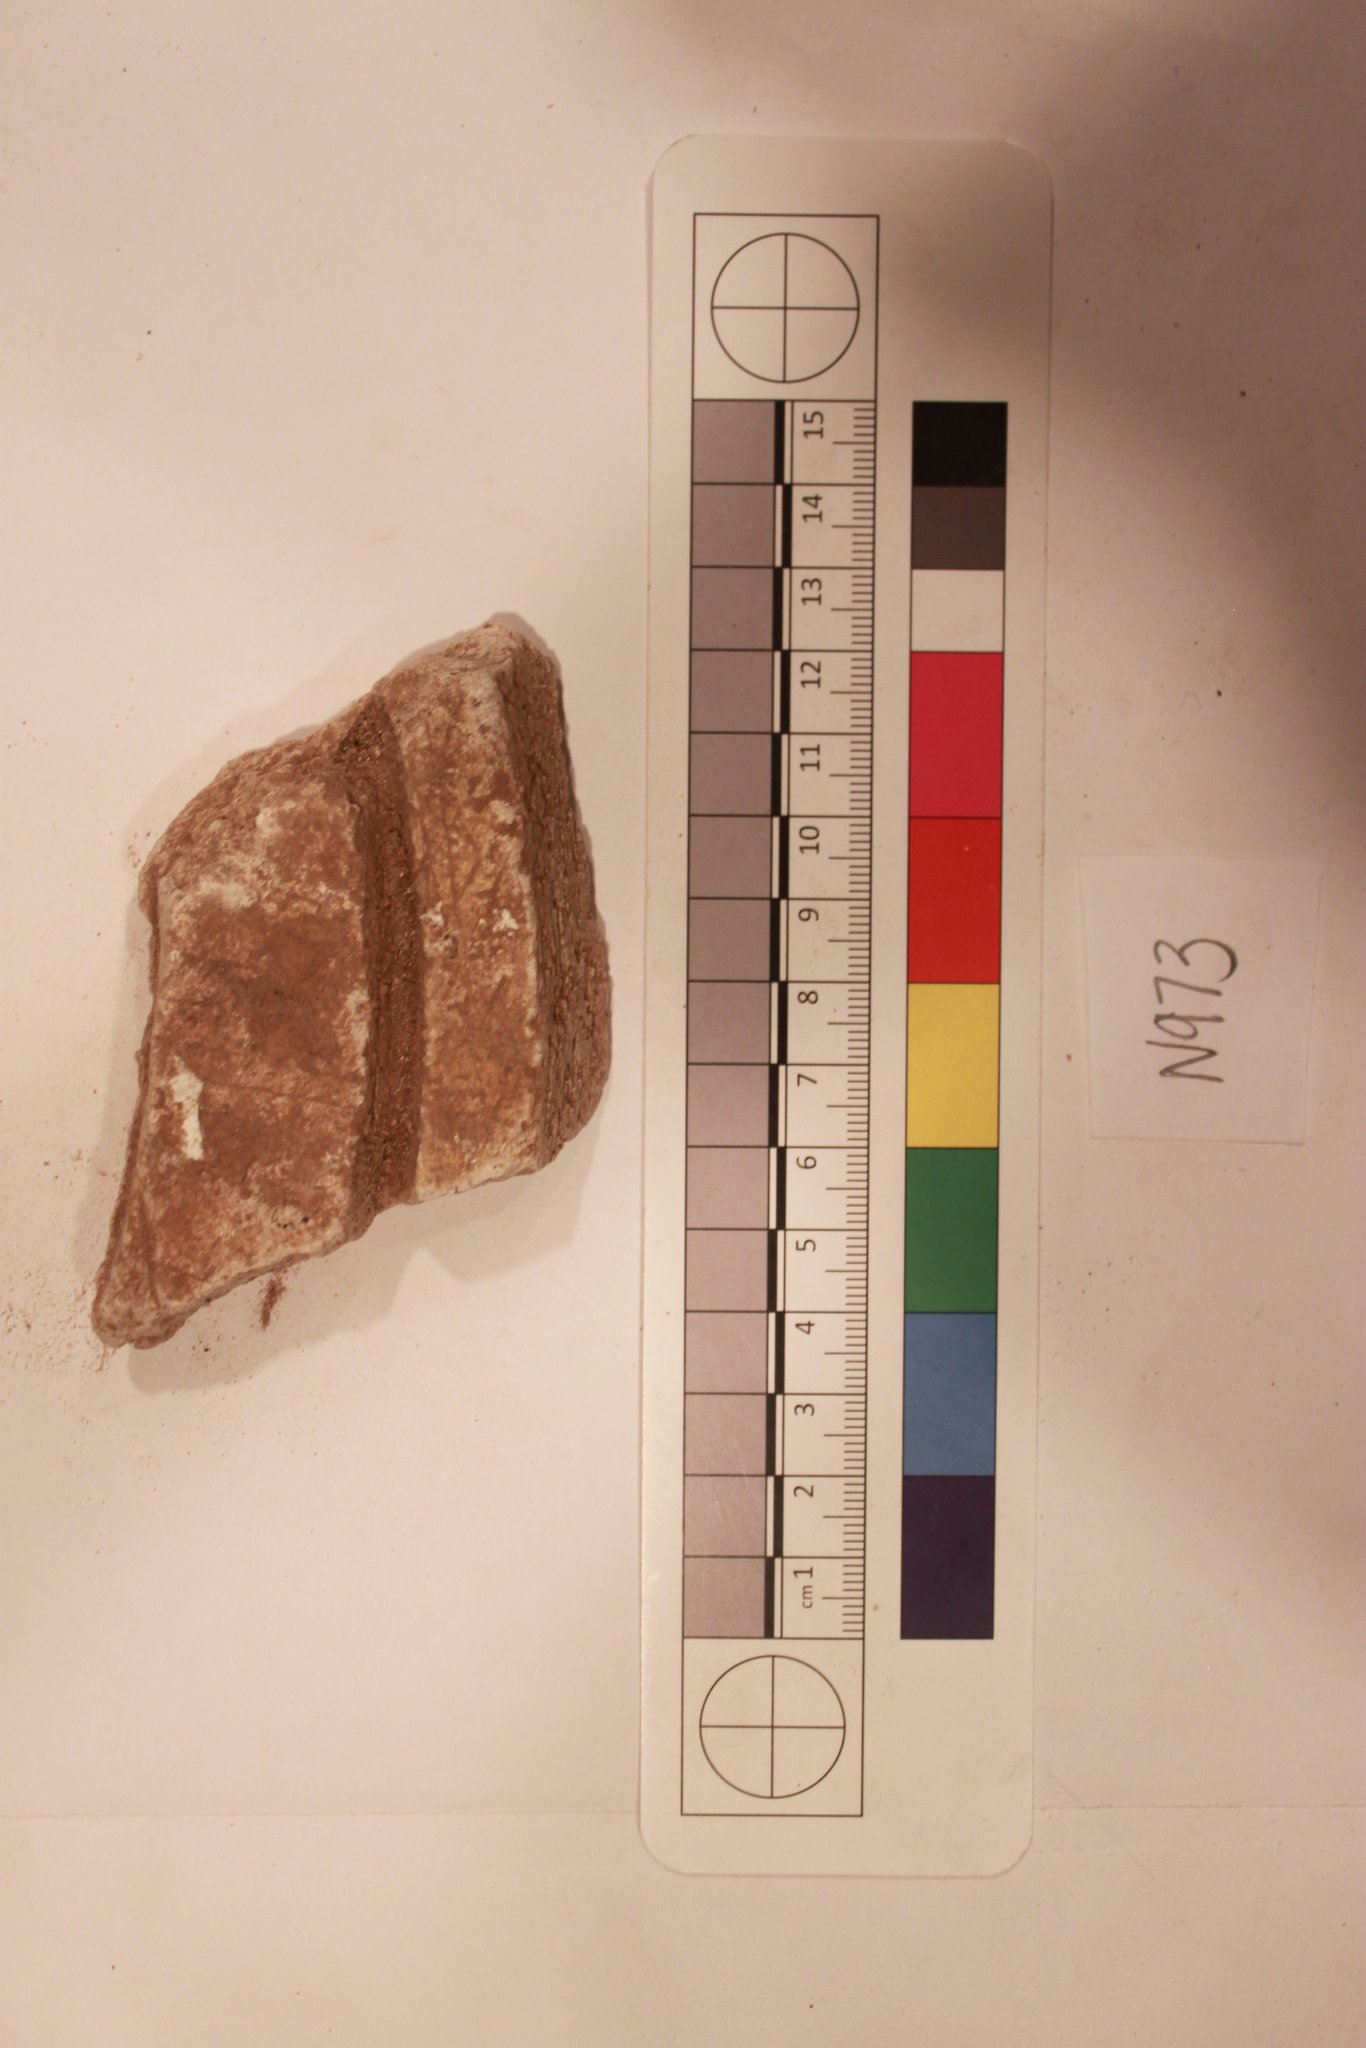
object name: fragment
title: Stucco Fragment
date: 701-1200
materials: plaster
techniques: carving, painting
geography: iran